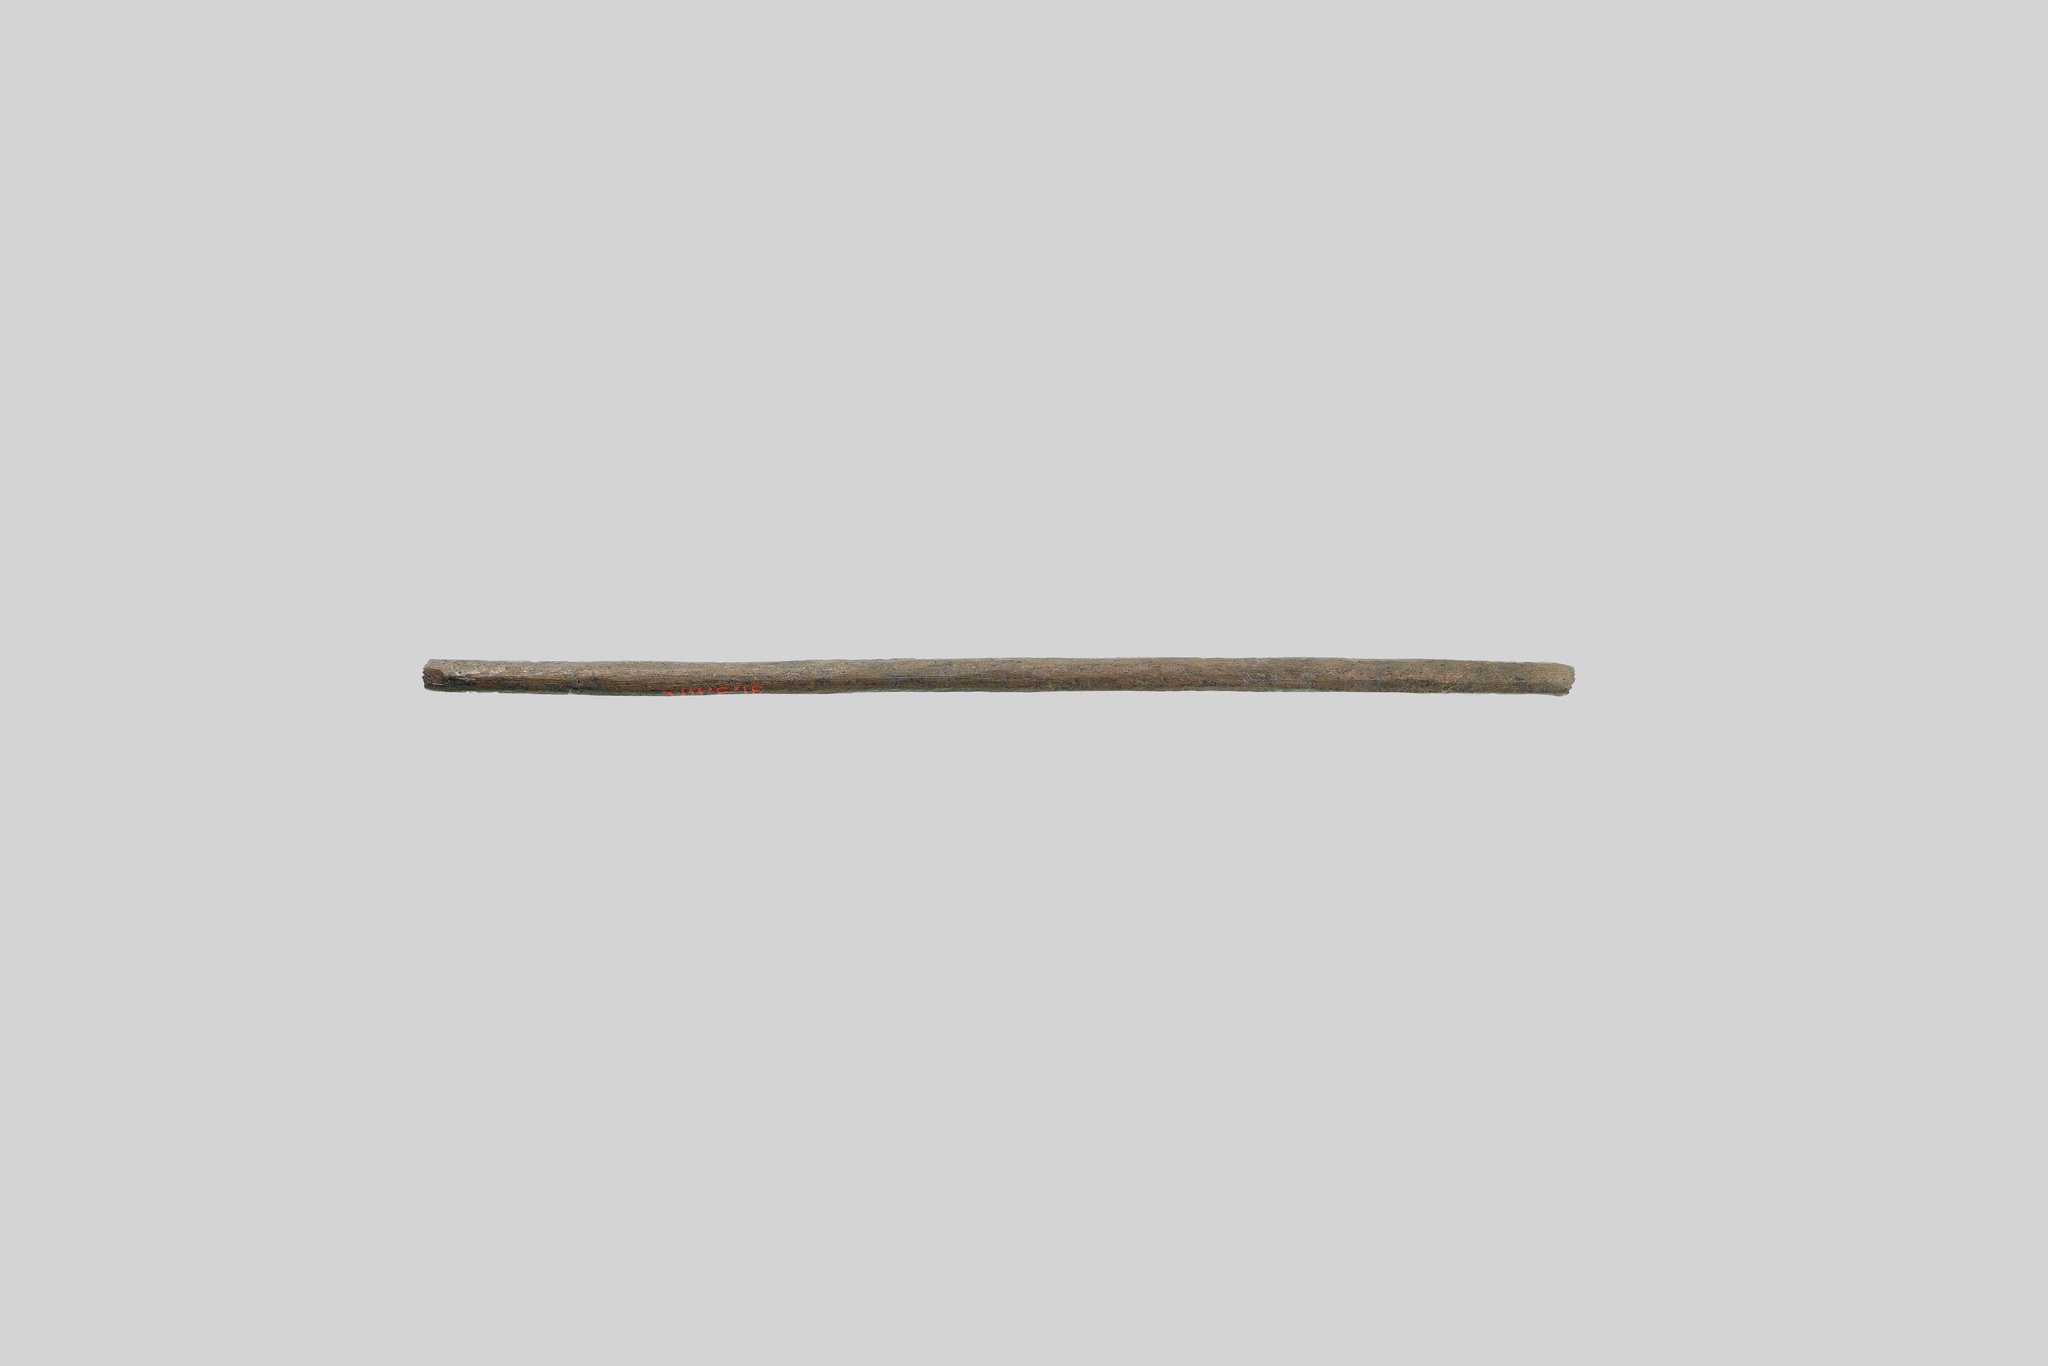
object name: rod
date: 664-332 BCE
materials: copper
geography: egypt